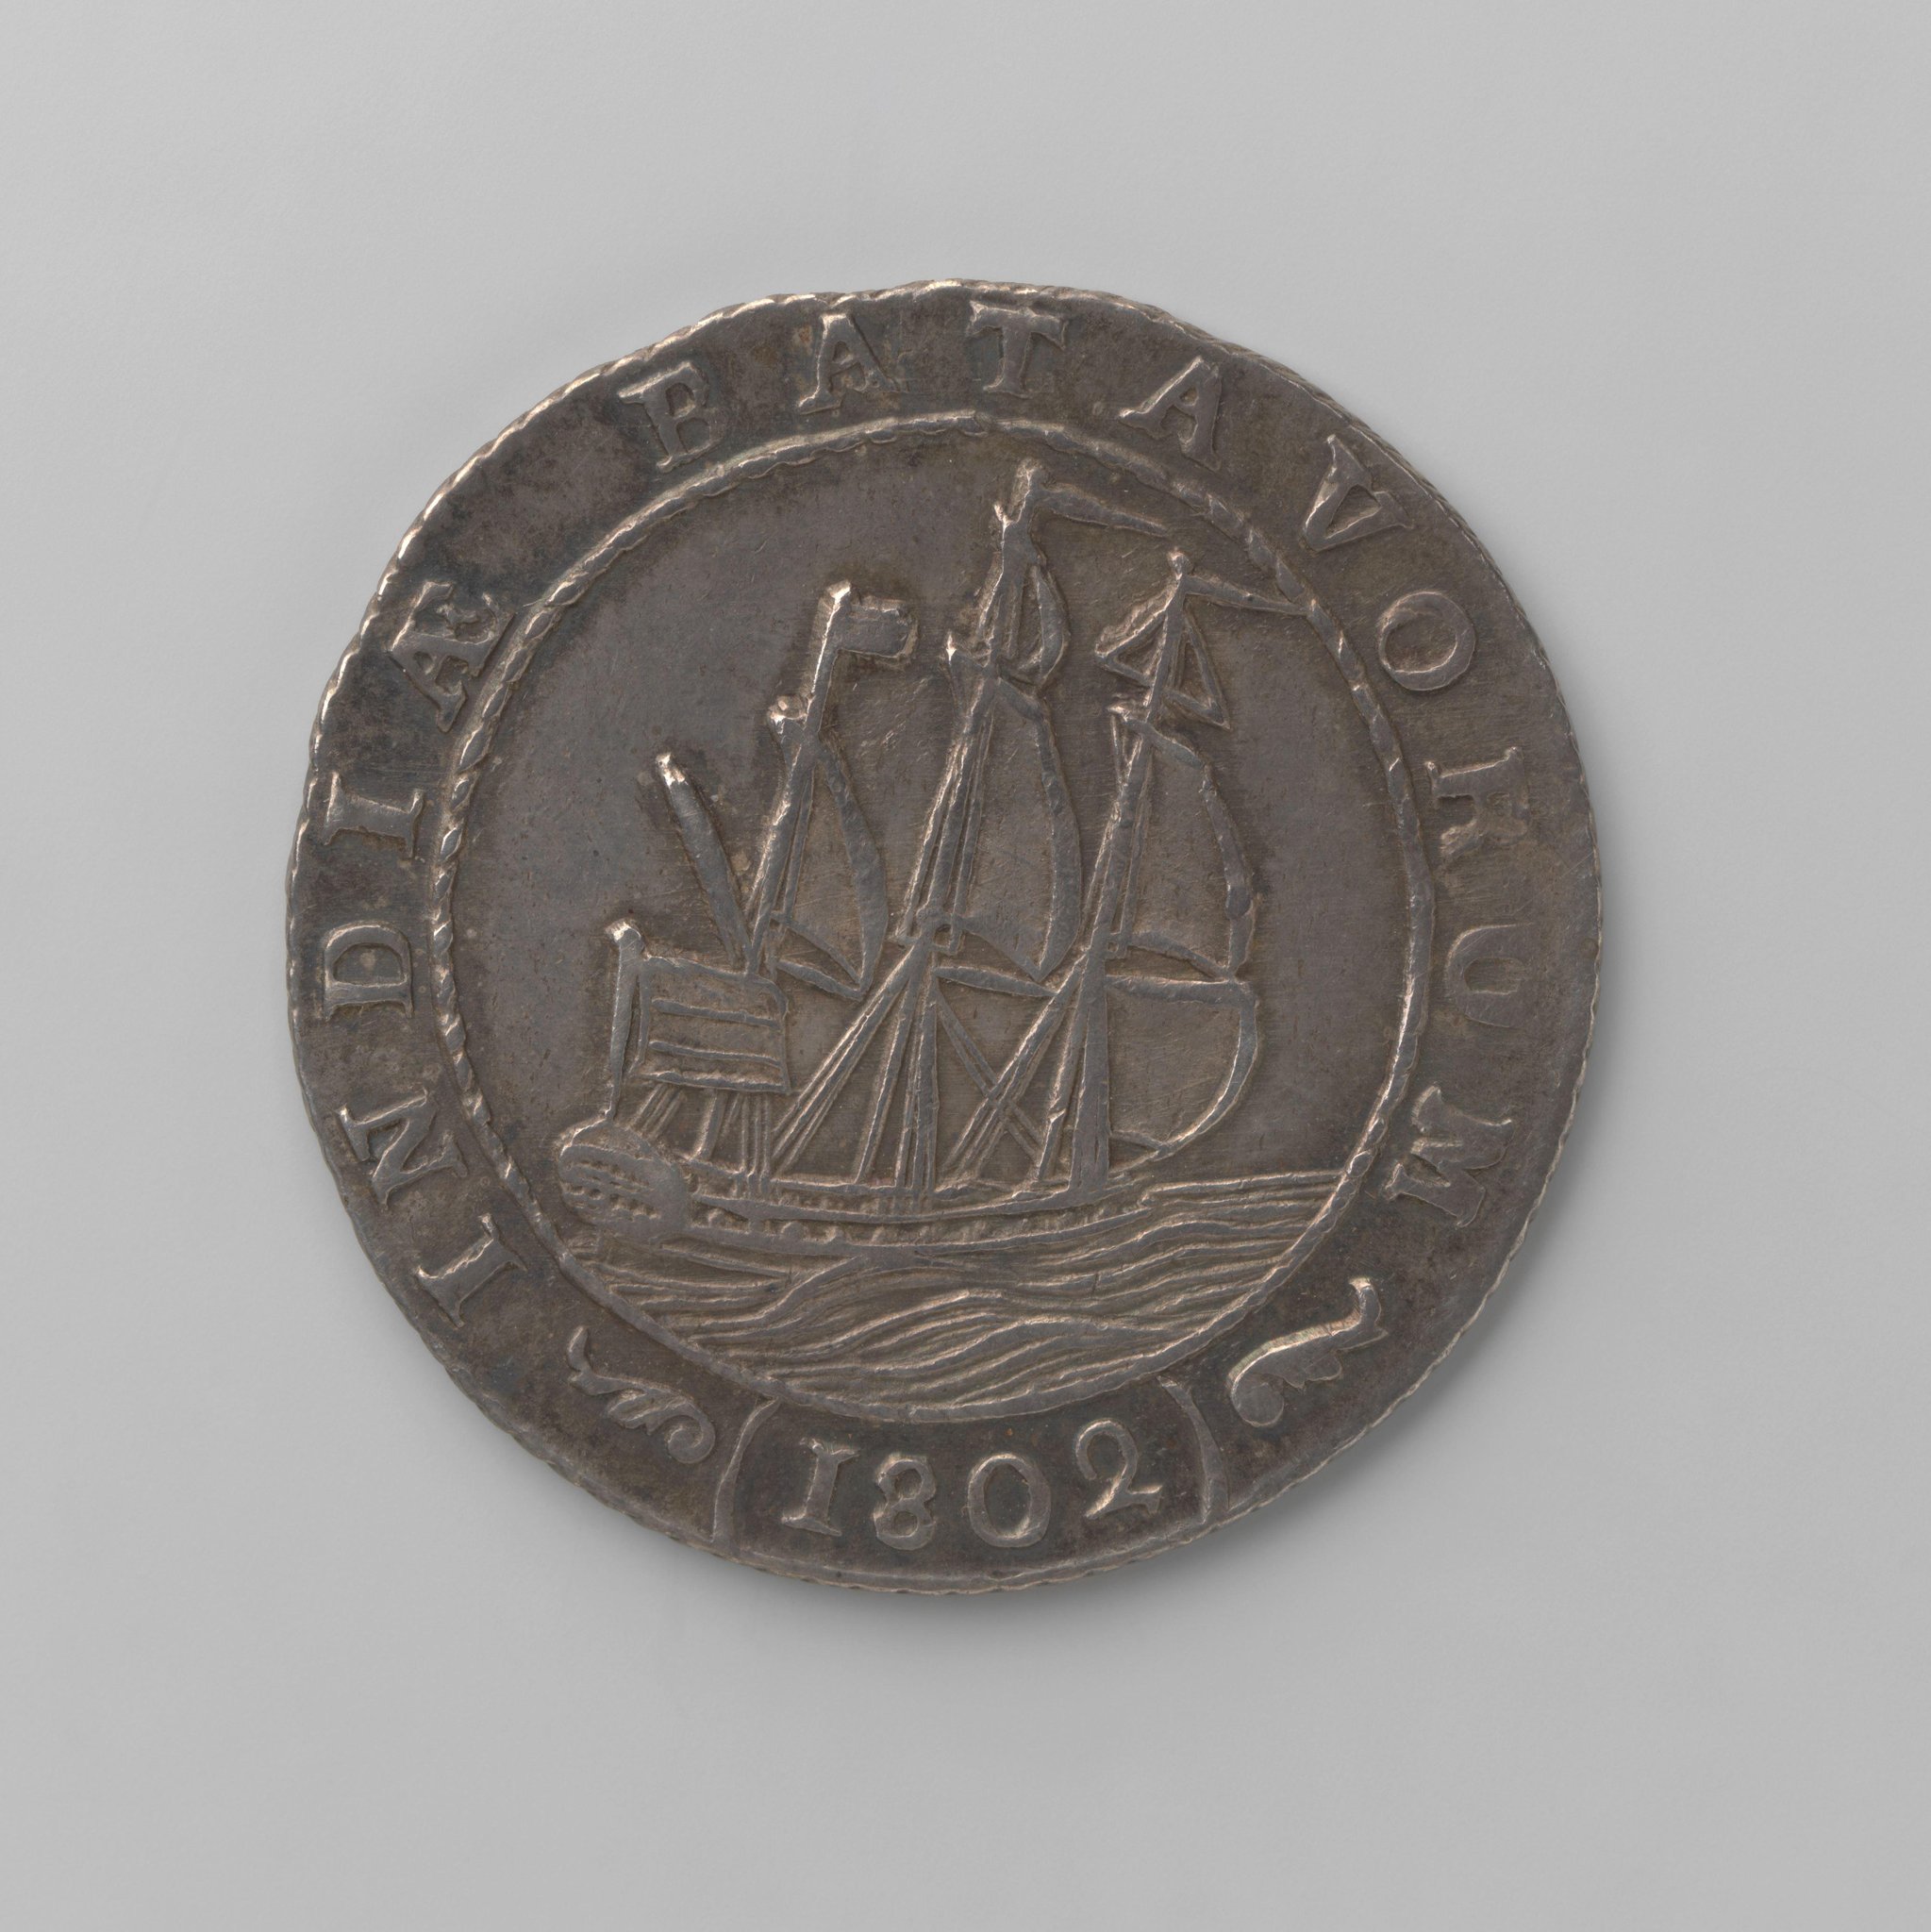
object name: coin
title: ½ gulden voor Nederlands Indië, 1802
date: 1802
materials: silver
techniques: striking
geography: enkhuizen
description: Zilveren munt. Voorzijde: Driemaster met volle zeilen op open zee. Versierd jaartal onderaan in omschrift. Keerzijde: tussen waarde-aanduiding ½ G gekroond generaliteitswapenschild. Muntteken boven kroon in omschrift. Kabelrand.